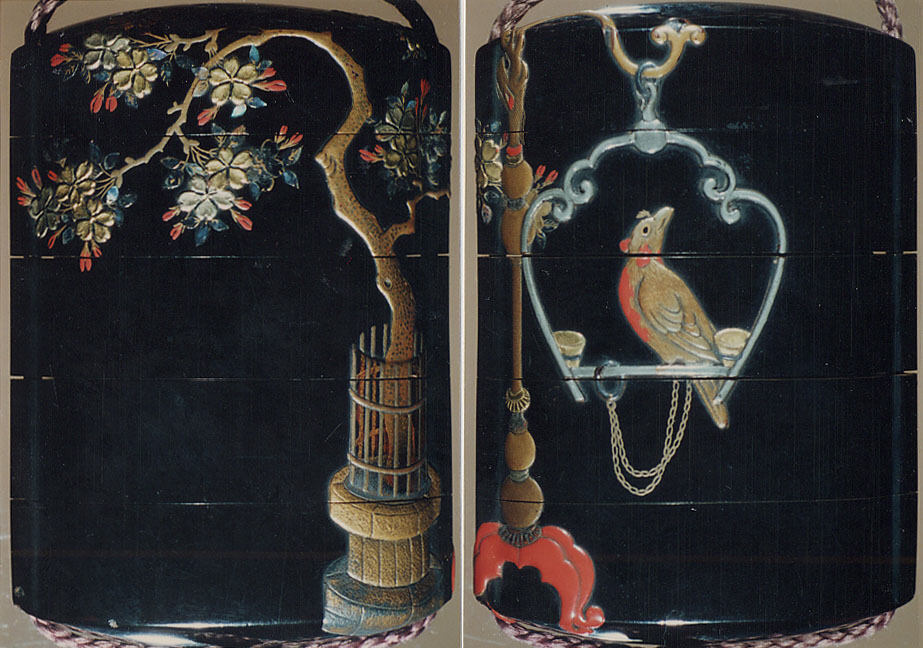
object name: inrō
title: Case (Inrō) with Flowering Cherry Tree (obverse); Parrot in Ornamental Swing (reverse)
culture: japanese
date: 1701-1900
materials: gold, lacquer, pewter, silver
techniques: fundame, hiramakie, inlay, roiro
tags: parrots,flowers,trees